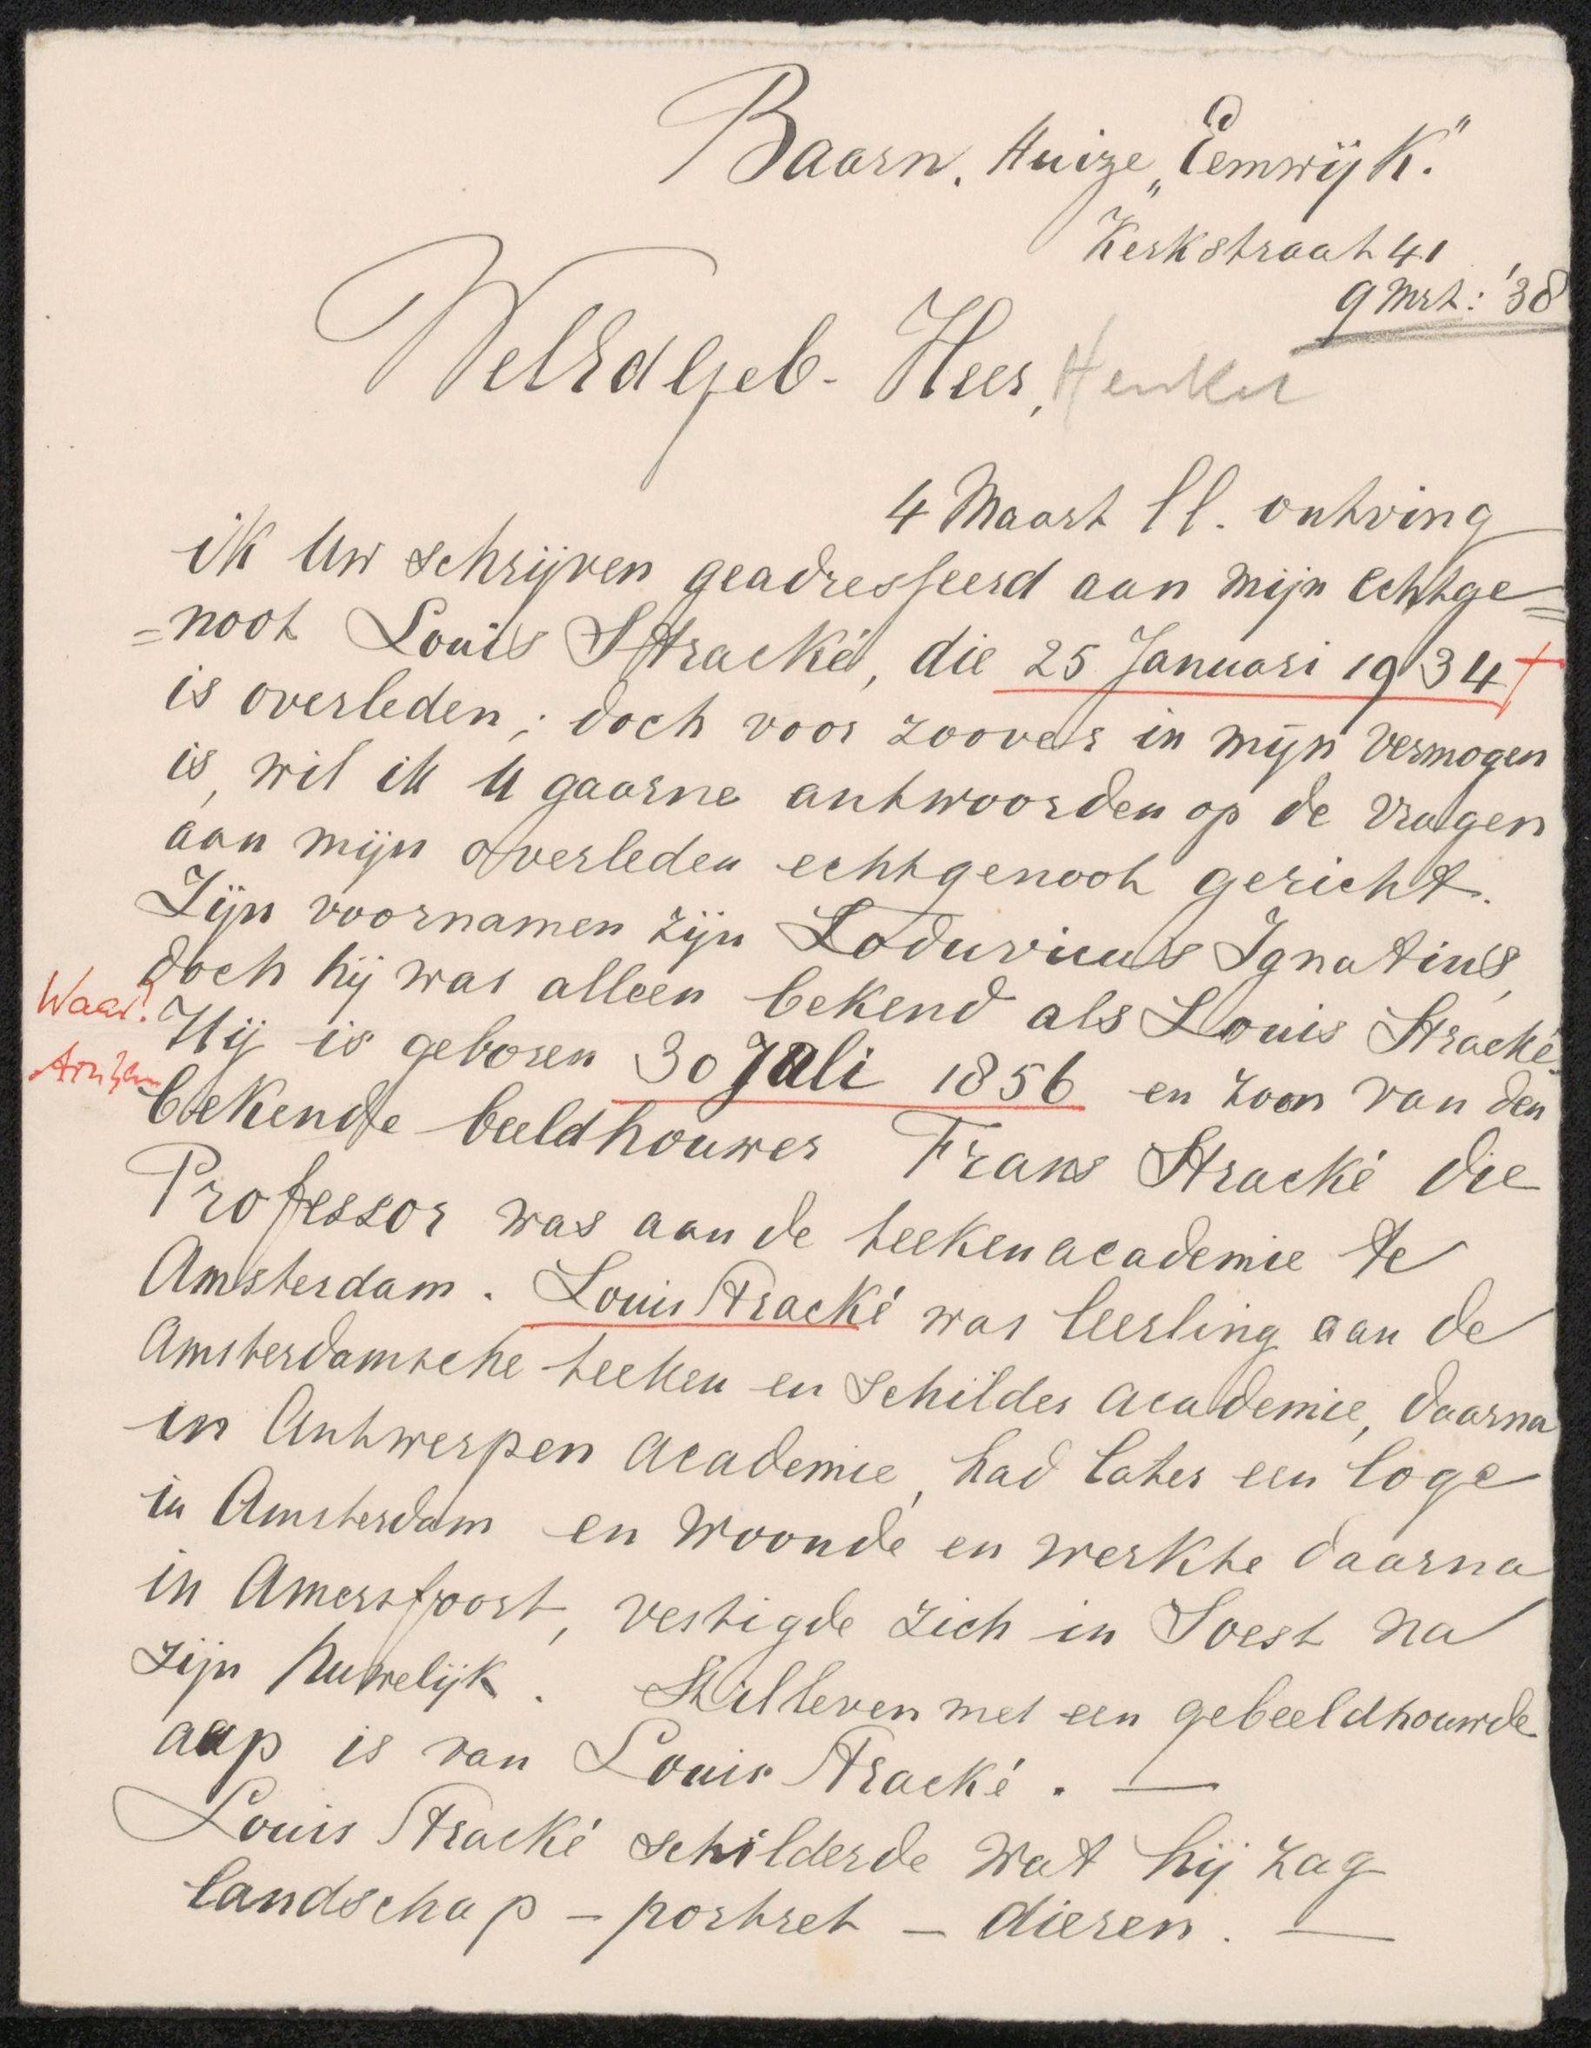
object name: letter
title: Brief aan Max Dittmar Henkel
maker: anna maria struben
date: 1938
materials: ink, paper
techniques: pen, writing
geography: baarn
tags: arnhem, louis stracké, max dittmar henkel, education, tuition of the artist (in general), painting (including book-illumination, miniature-painting), exhibition ~ art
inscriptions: collector's mark: ‘RPK’